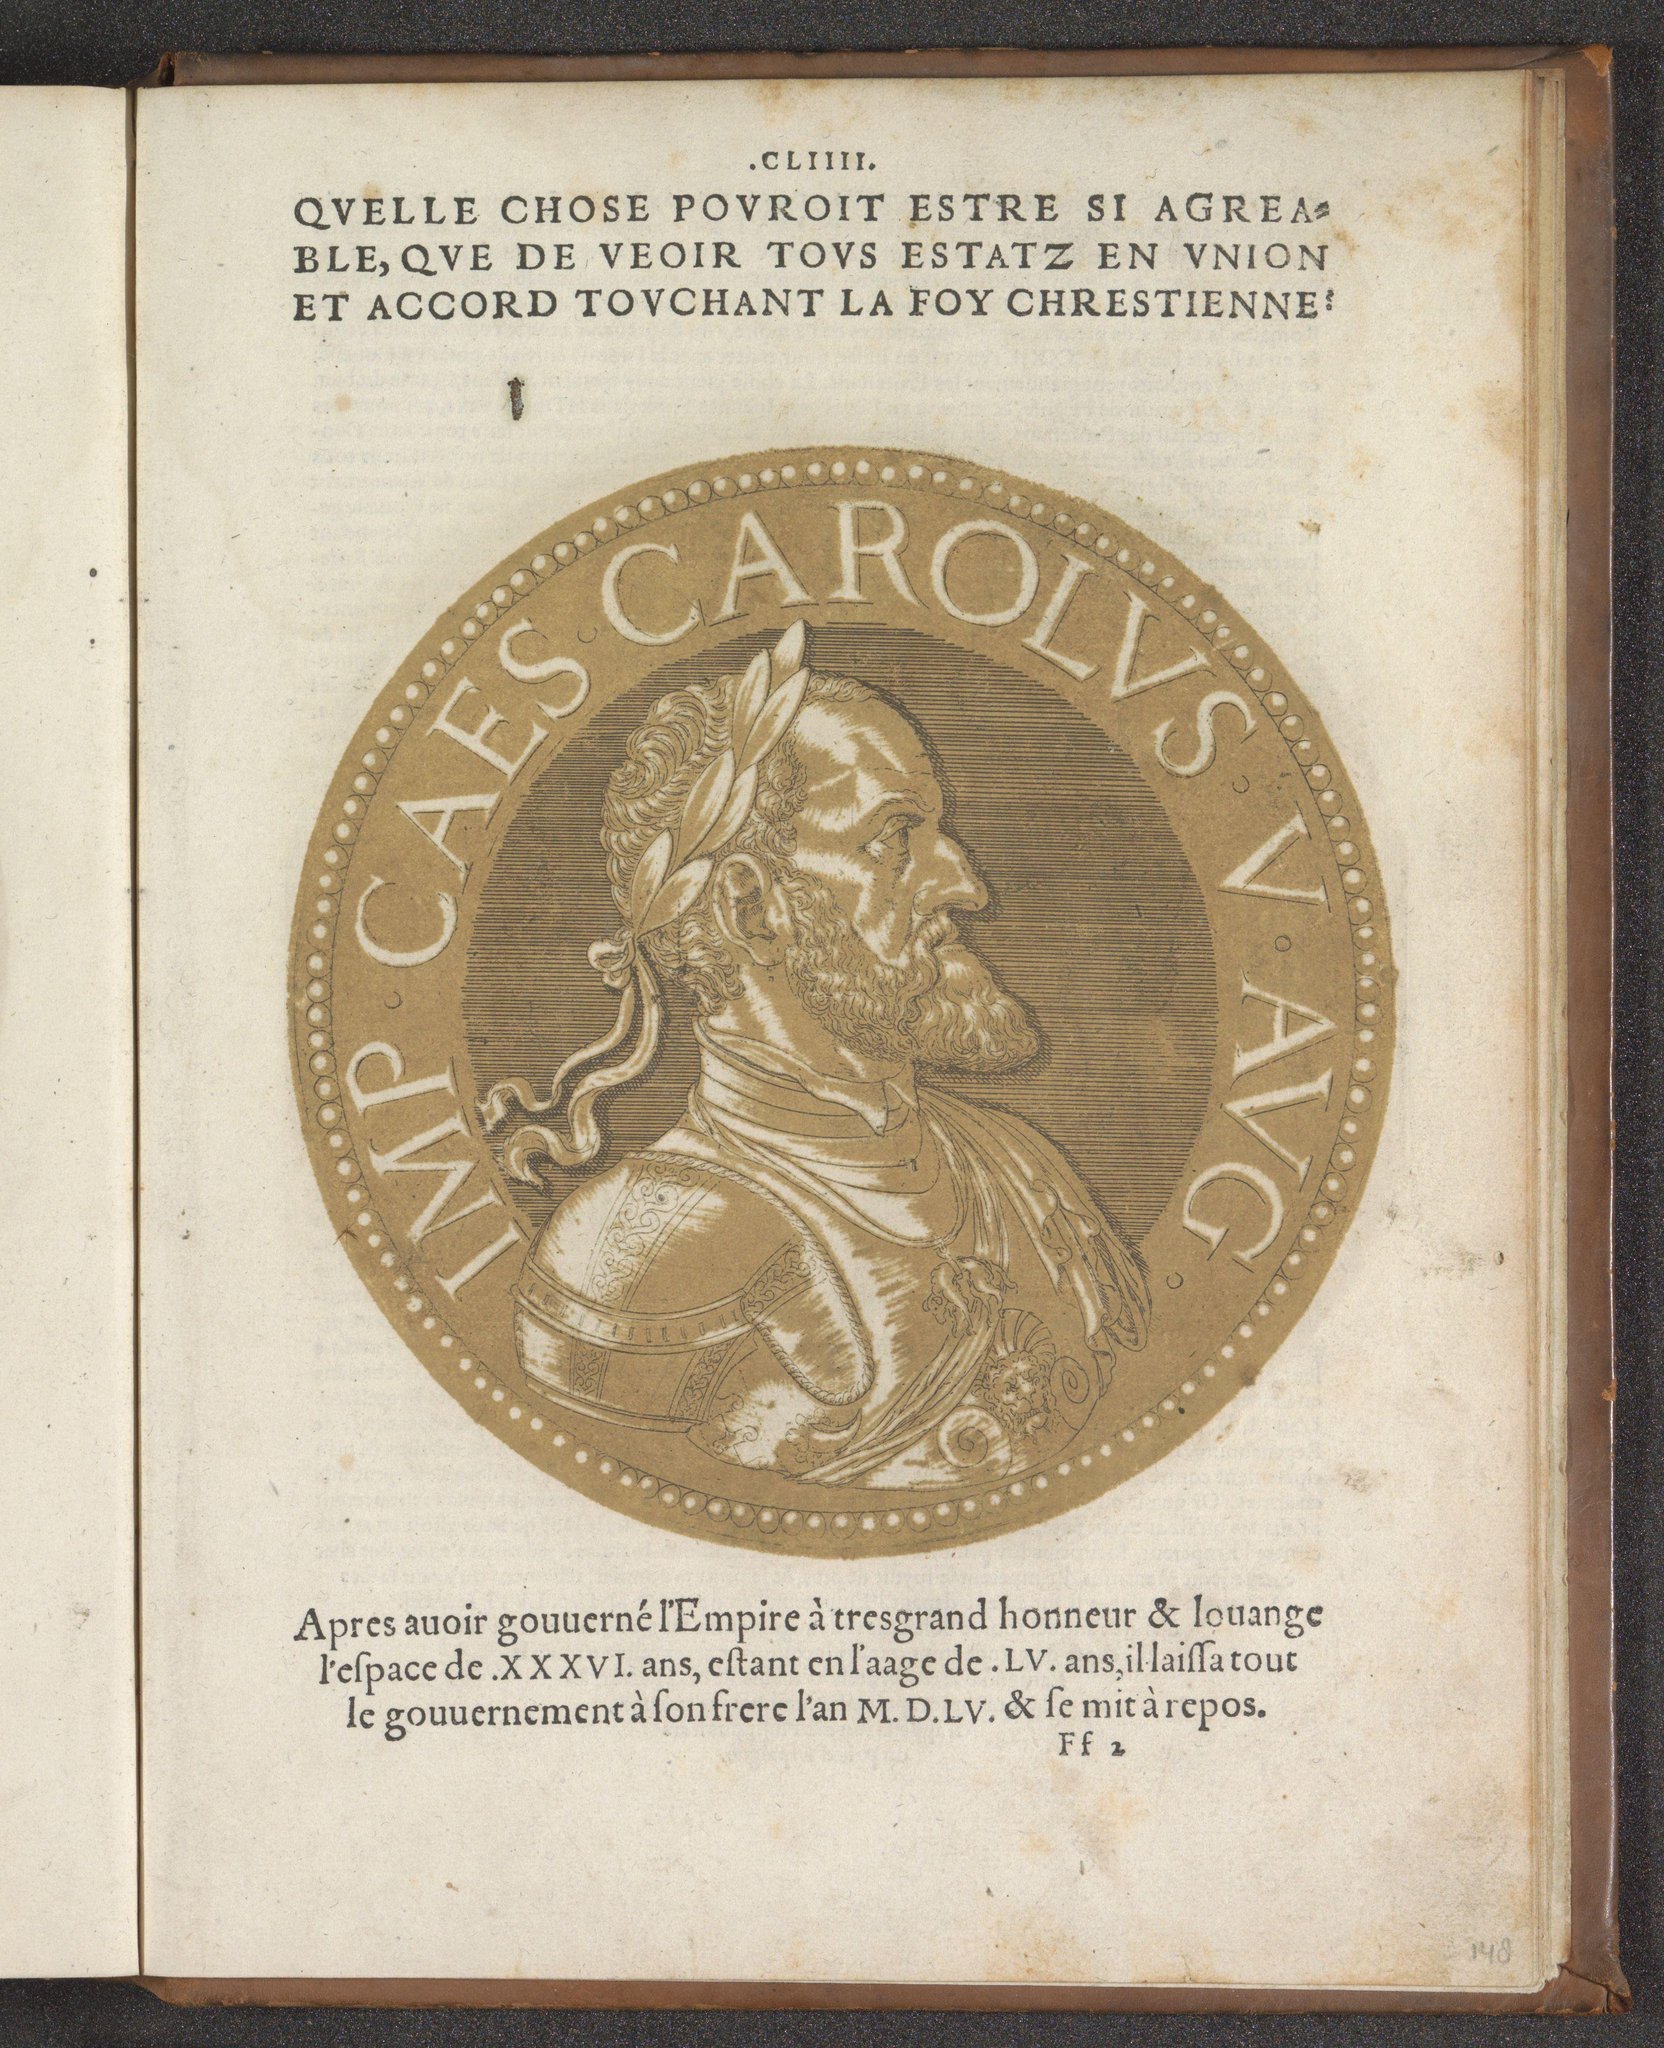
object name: page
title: Les images presque de tous les empereurs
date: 1557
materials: paper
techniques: woodcut, etching, letterpress printing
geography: antwerp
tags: charles v (holy roman emperor and king of spain), emperor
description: Portret van keizer Karel V, op een munt met randschrift. De prent maakt deel uit van een boek over de keizers vanaf Julius Caesar tot en met Karel V en zijn broer Ferdinand.